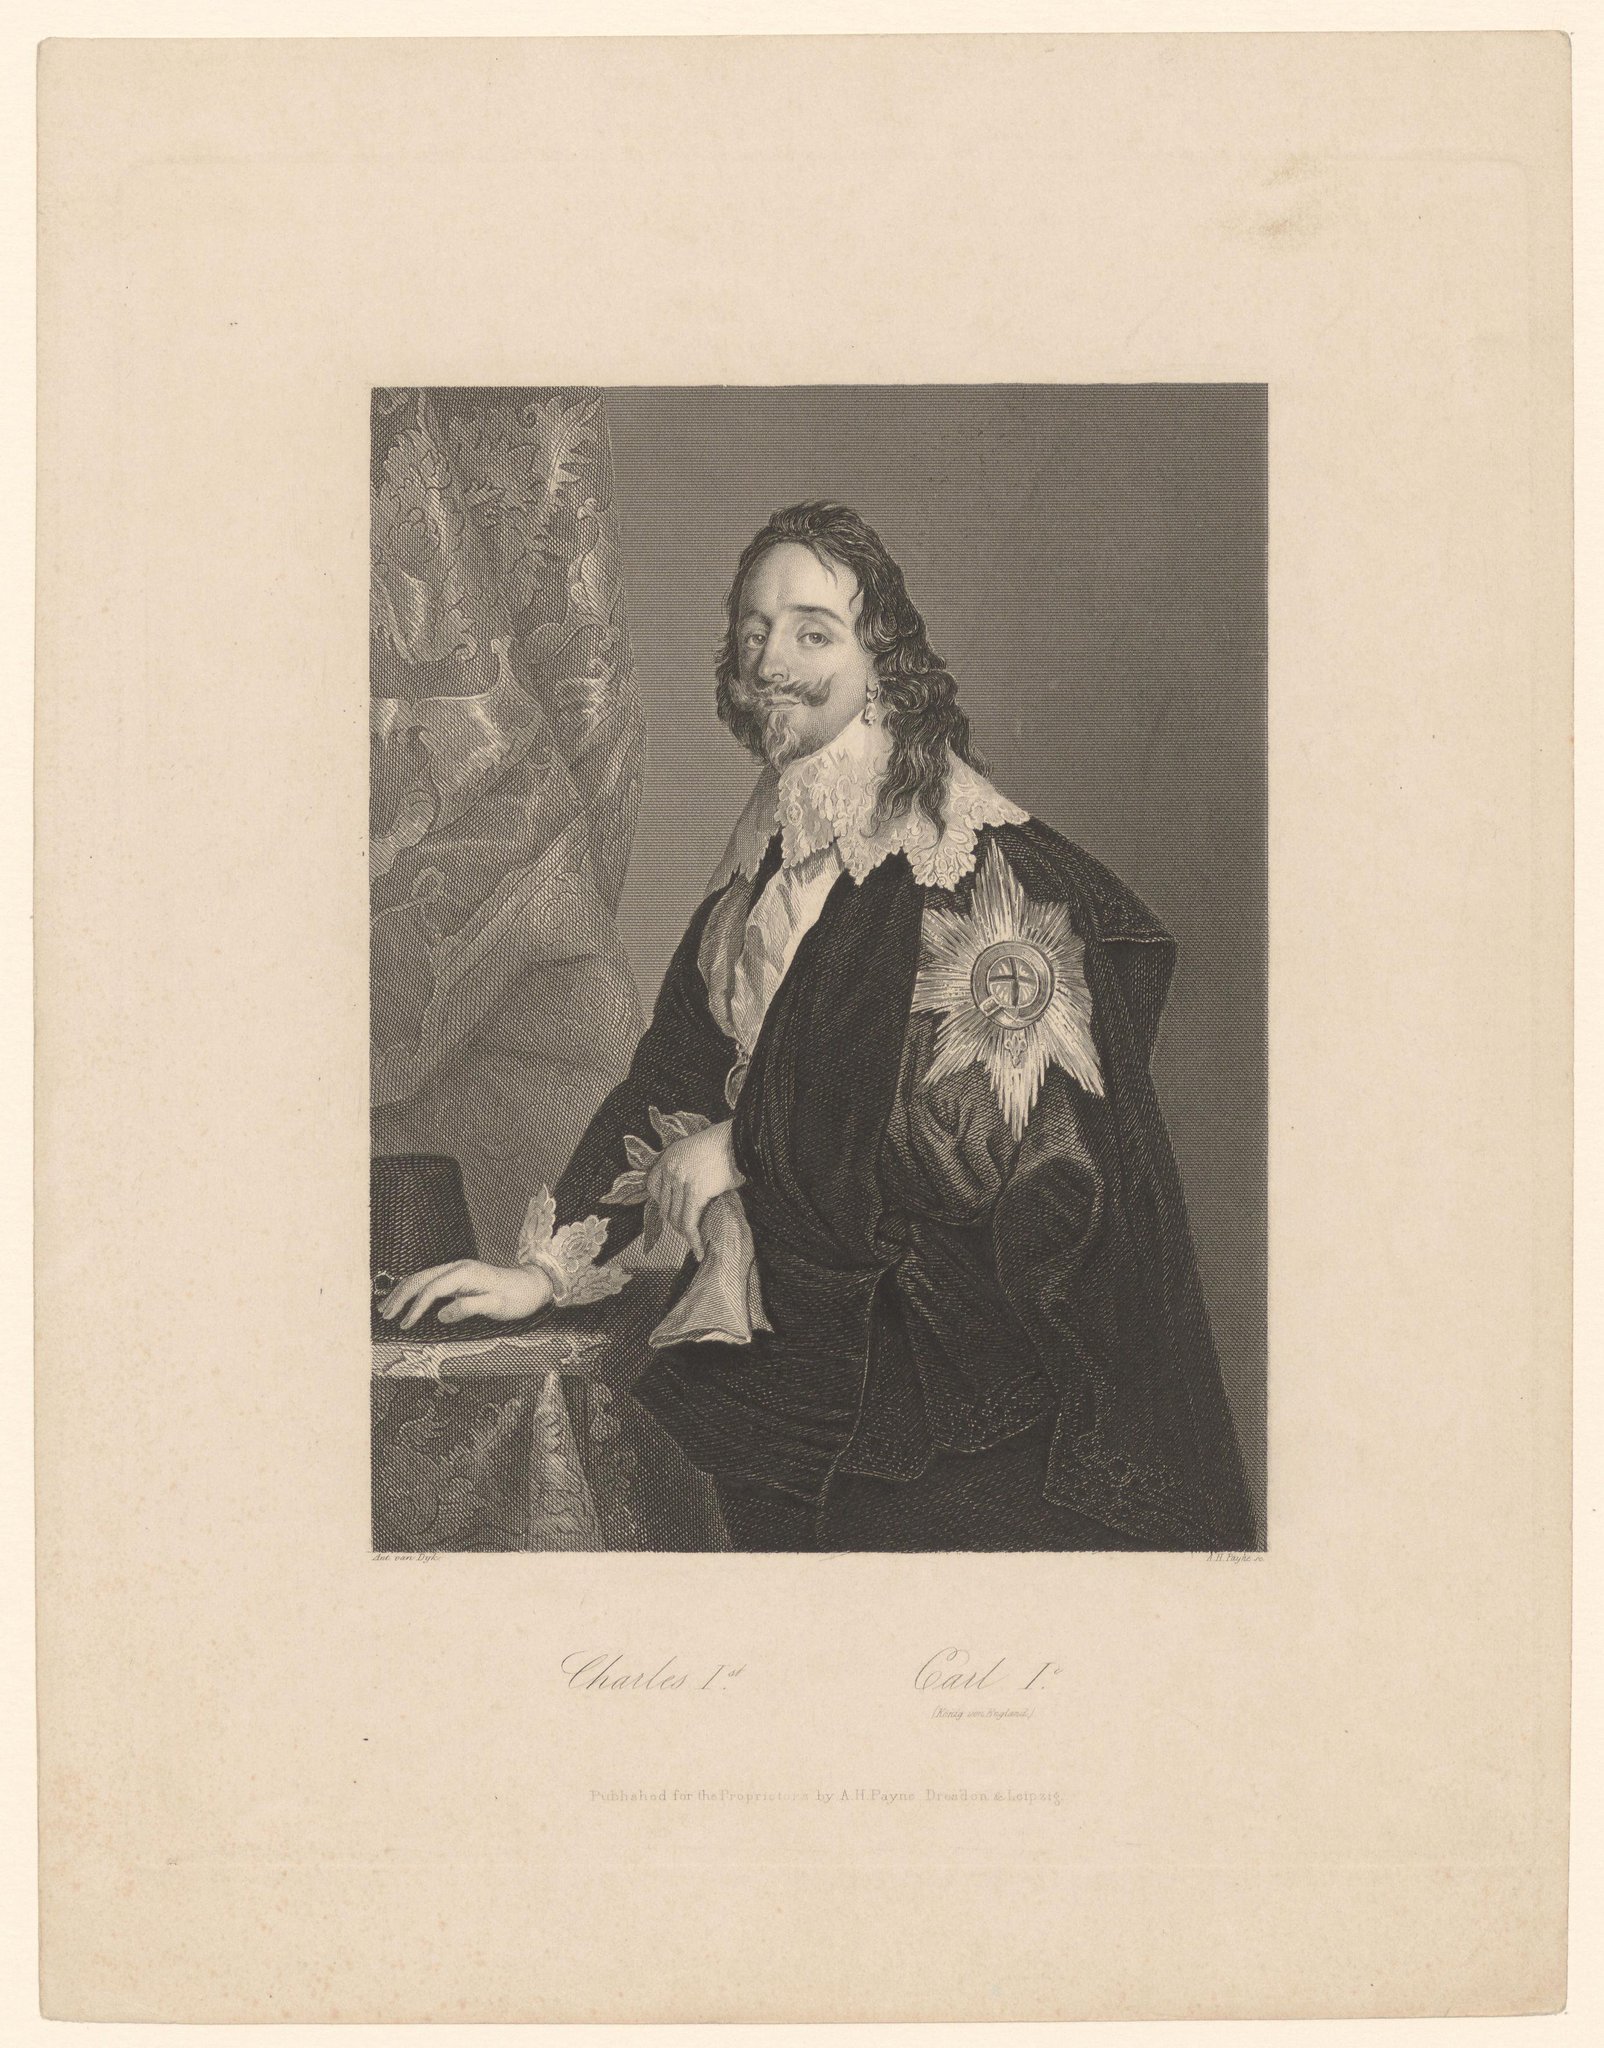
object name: print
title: Charles Ist / Carl Ie (König von England)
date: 1845-1902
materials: paper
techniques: etching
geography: dresden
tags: london, karel i (koning van engeland), historical persons, king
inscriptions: collector's mark: Lugt 2228